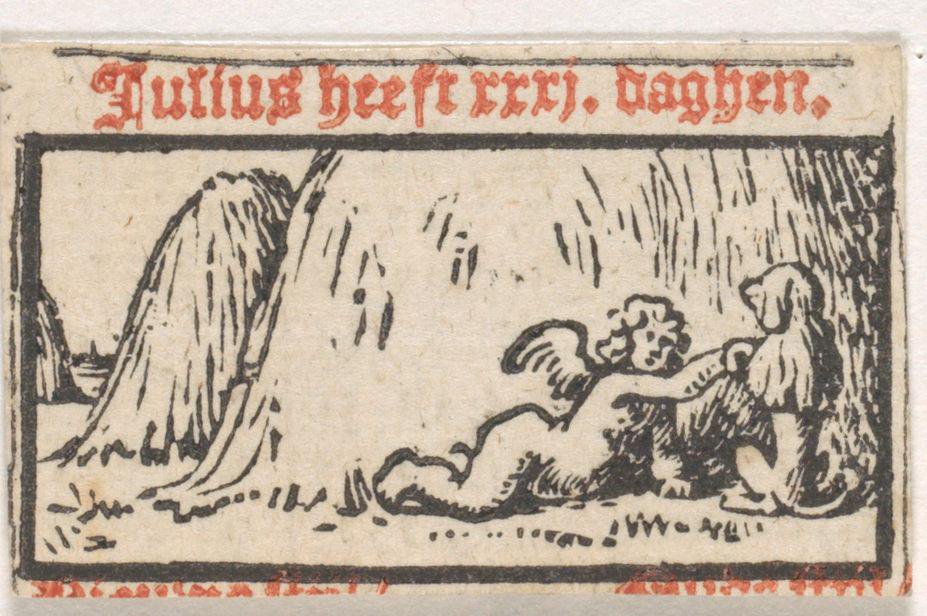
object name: print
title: Maanden van het jaar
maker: dirck de bray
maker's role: draughtsman, painter, print maker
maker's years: 1625-1694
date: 1635-1694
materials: paper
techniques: letterpress printing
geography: netherlands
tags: july and its 'labours' (+ with leo (july))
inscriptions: collector's mark: Lugt 2228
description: Een putto ligt naast een hooiberg en aait een hond (leeuw?). In de bovenmarge een regel Nederlandse tekst.